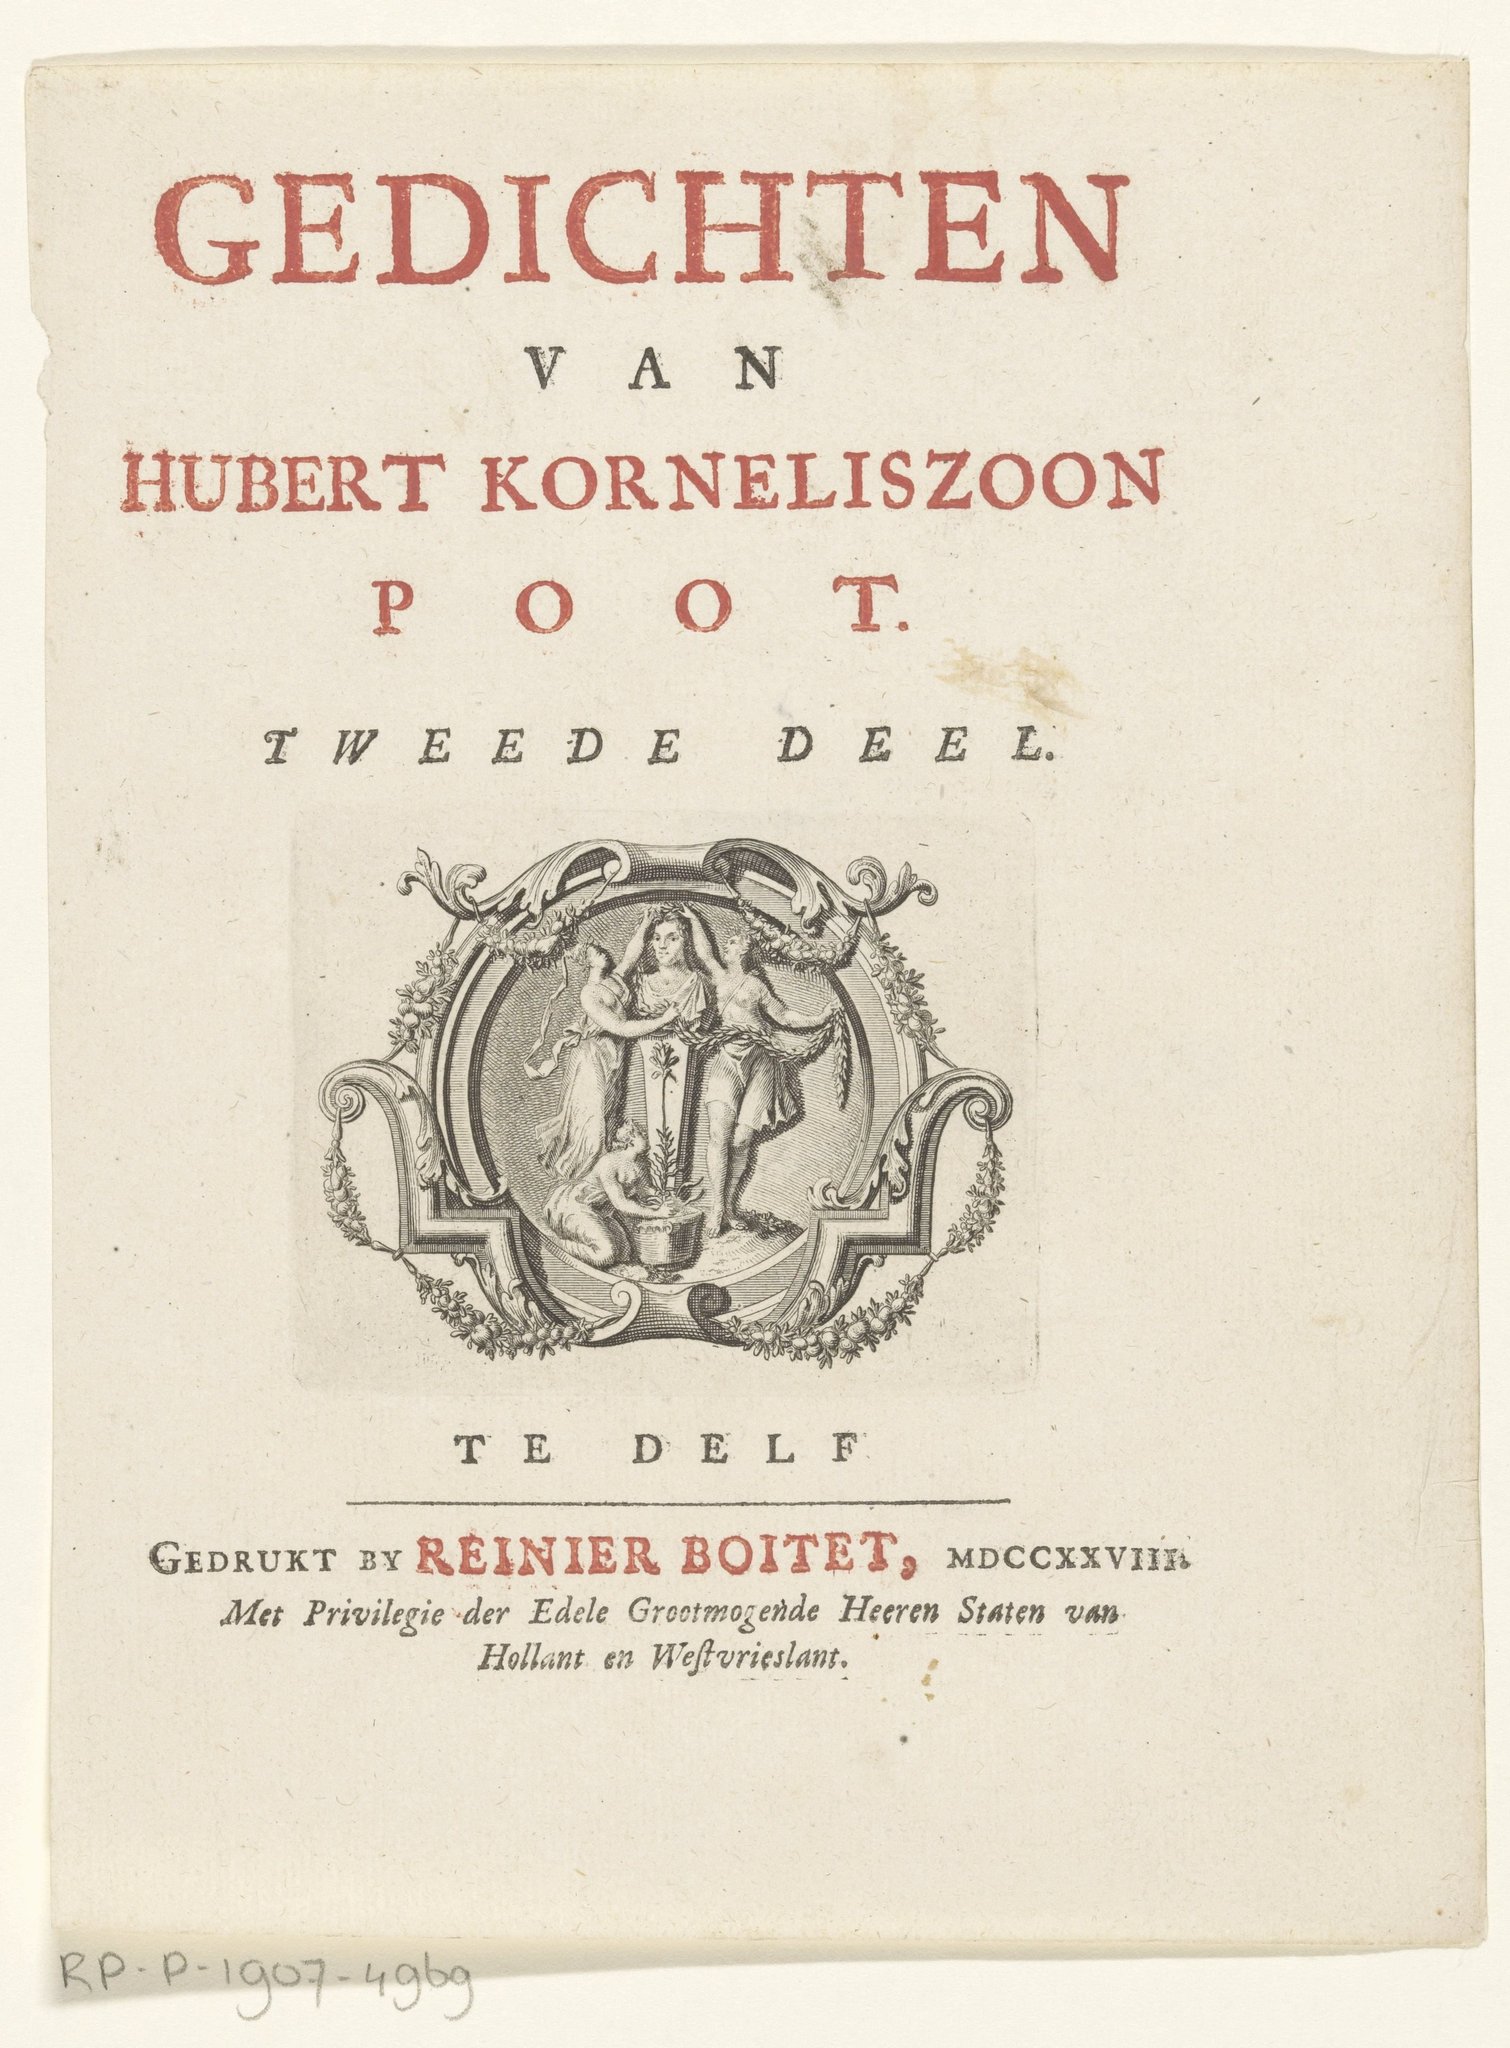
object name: print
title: Titelpagina voor: Hubert Cornelisz Poot, Gedichten, Tweede deel, 1728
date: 1728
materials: paper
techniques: engraving, letterpress printing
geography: delft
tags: herms (garden ornaments), ornamenting, decorating ~ applied arts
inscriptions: collector's mark: Lugt 2760, collector's mark: Lugt 2228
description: Titelpagina voor: Poot, Hubert Cornelisz. Gedichten, Tweede deel. Delft: Boitet, Reinier, 1728.